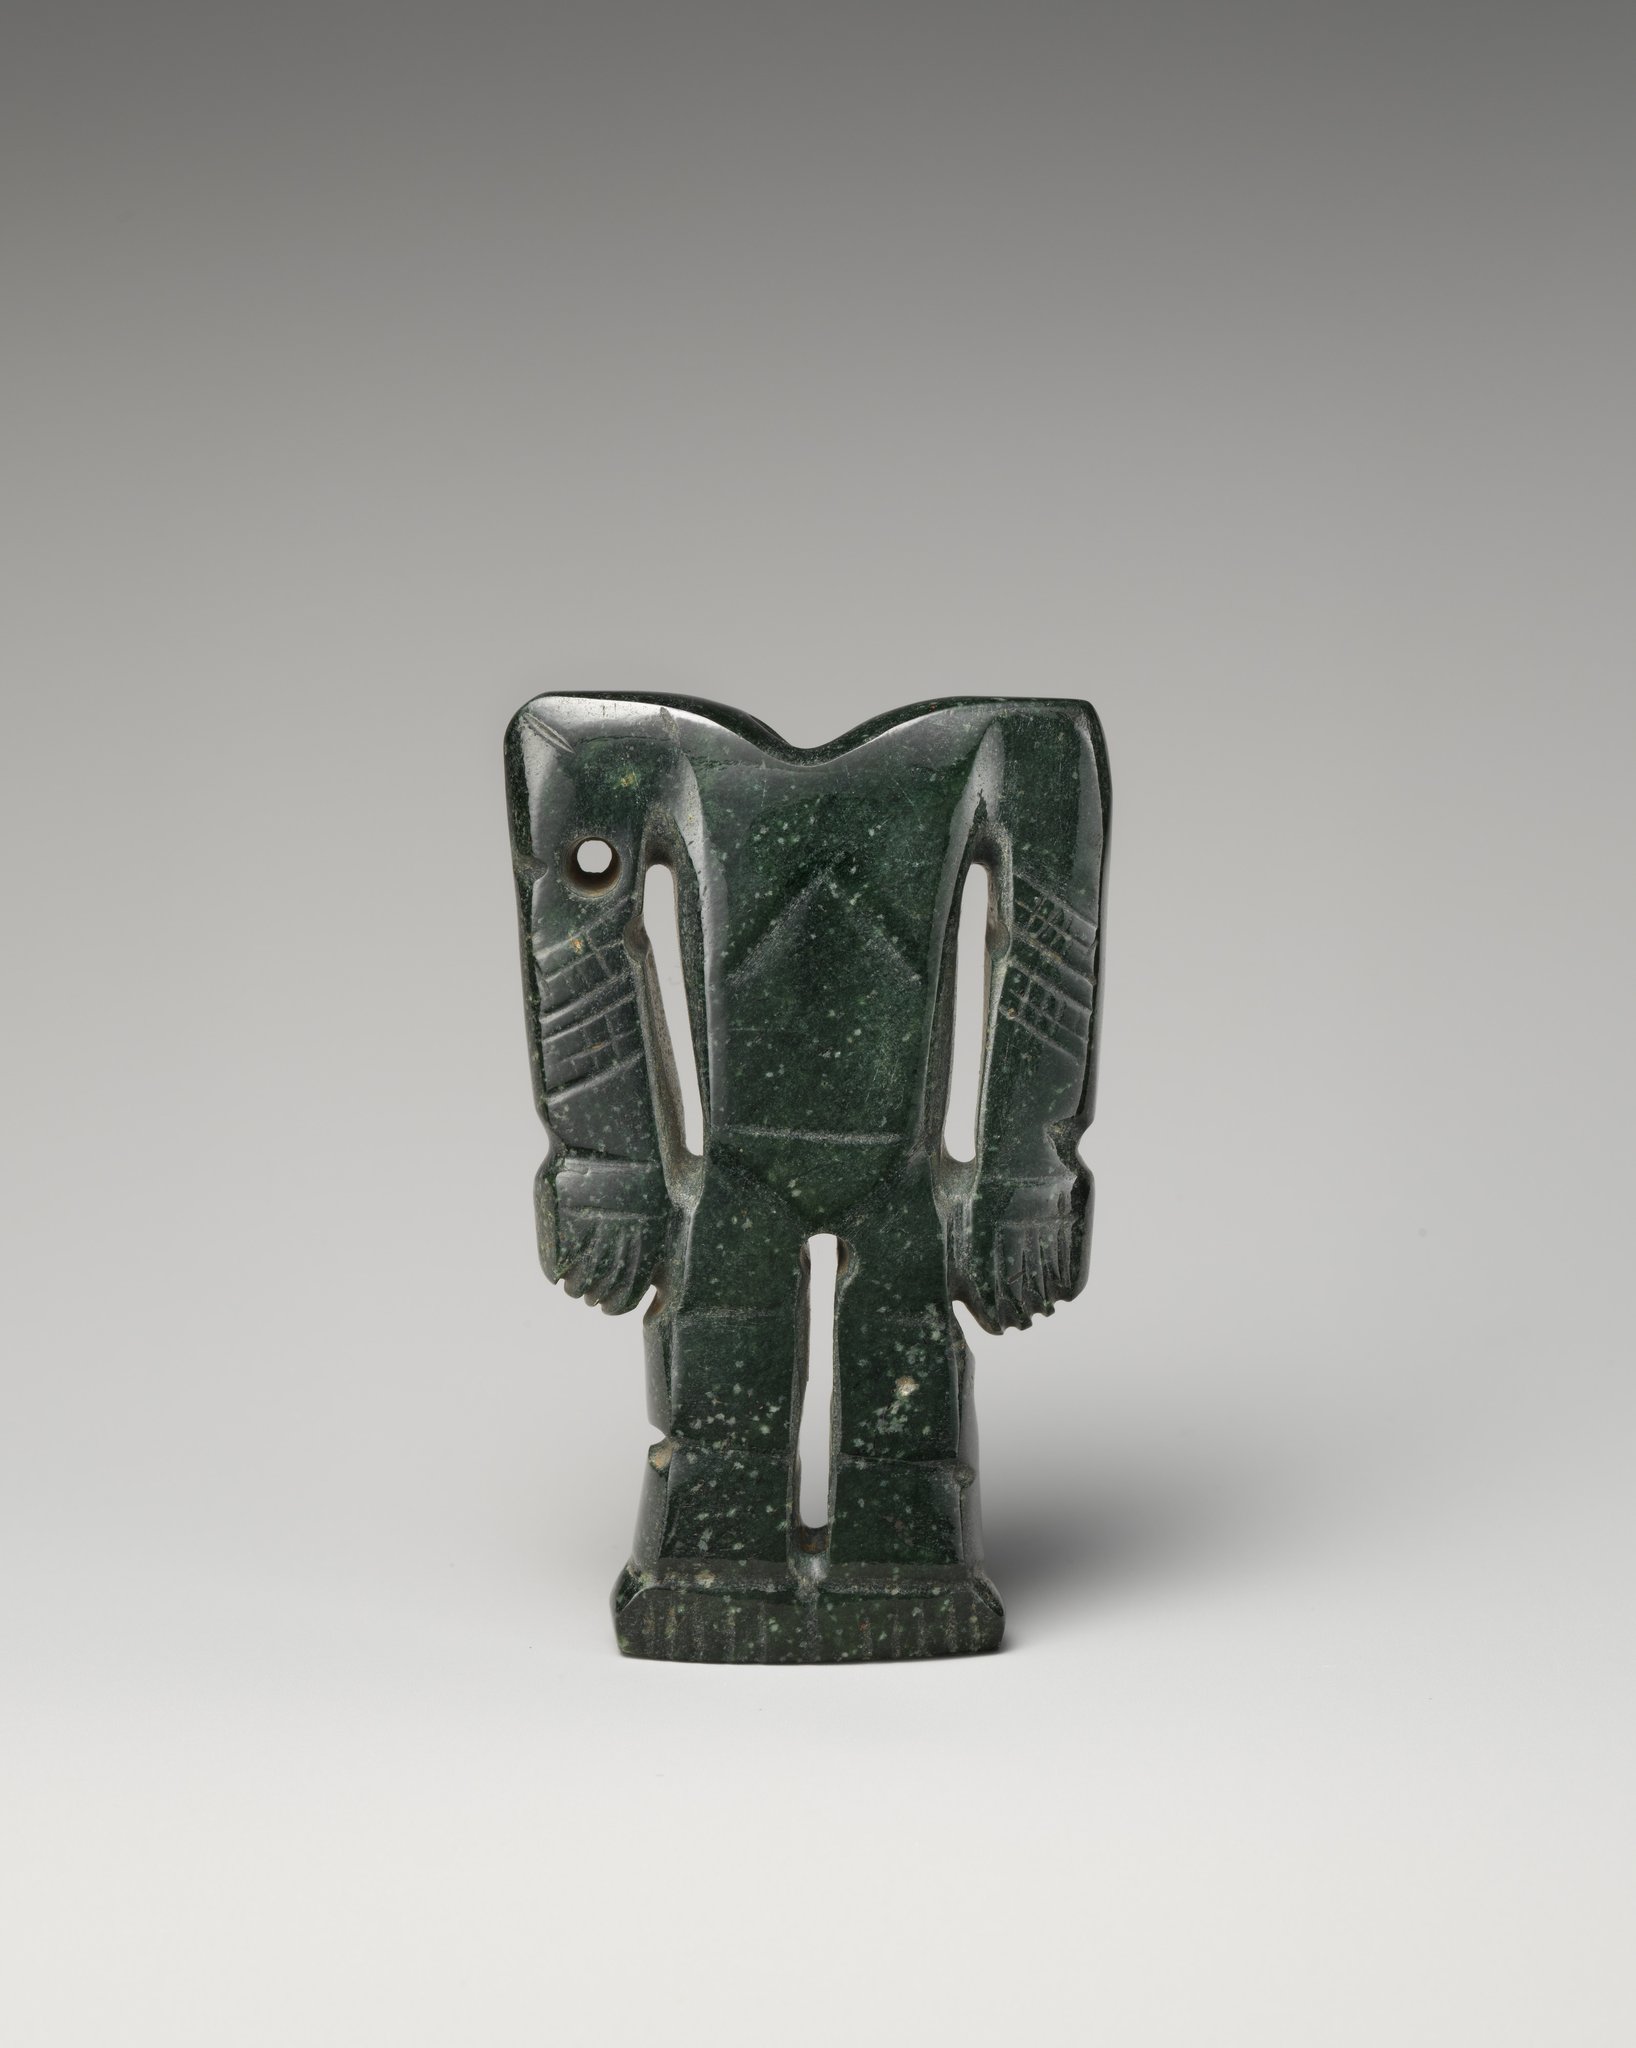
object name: pendant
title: Headless Anthropomorphic Pendant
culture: central region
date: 301-700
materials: jade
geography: costa rica